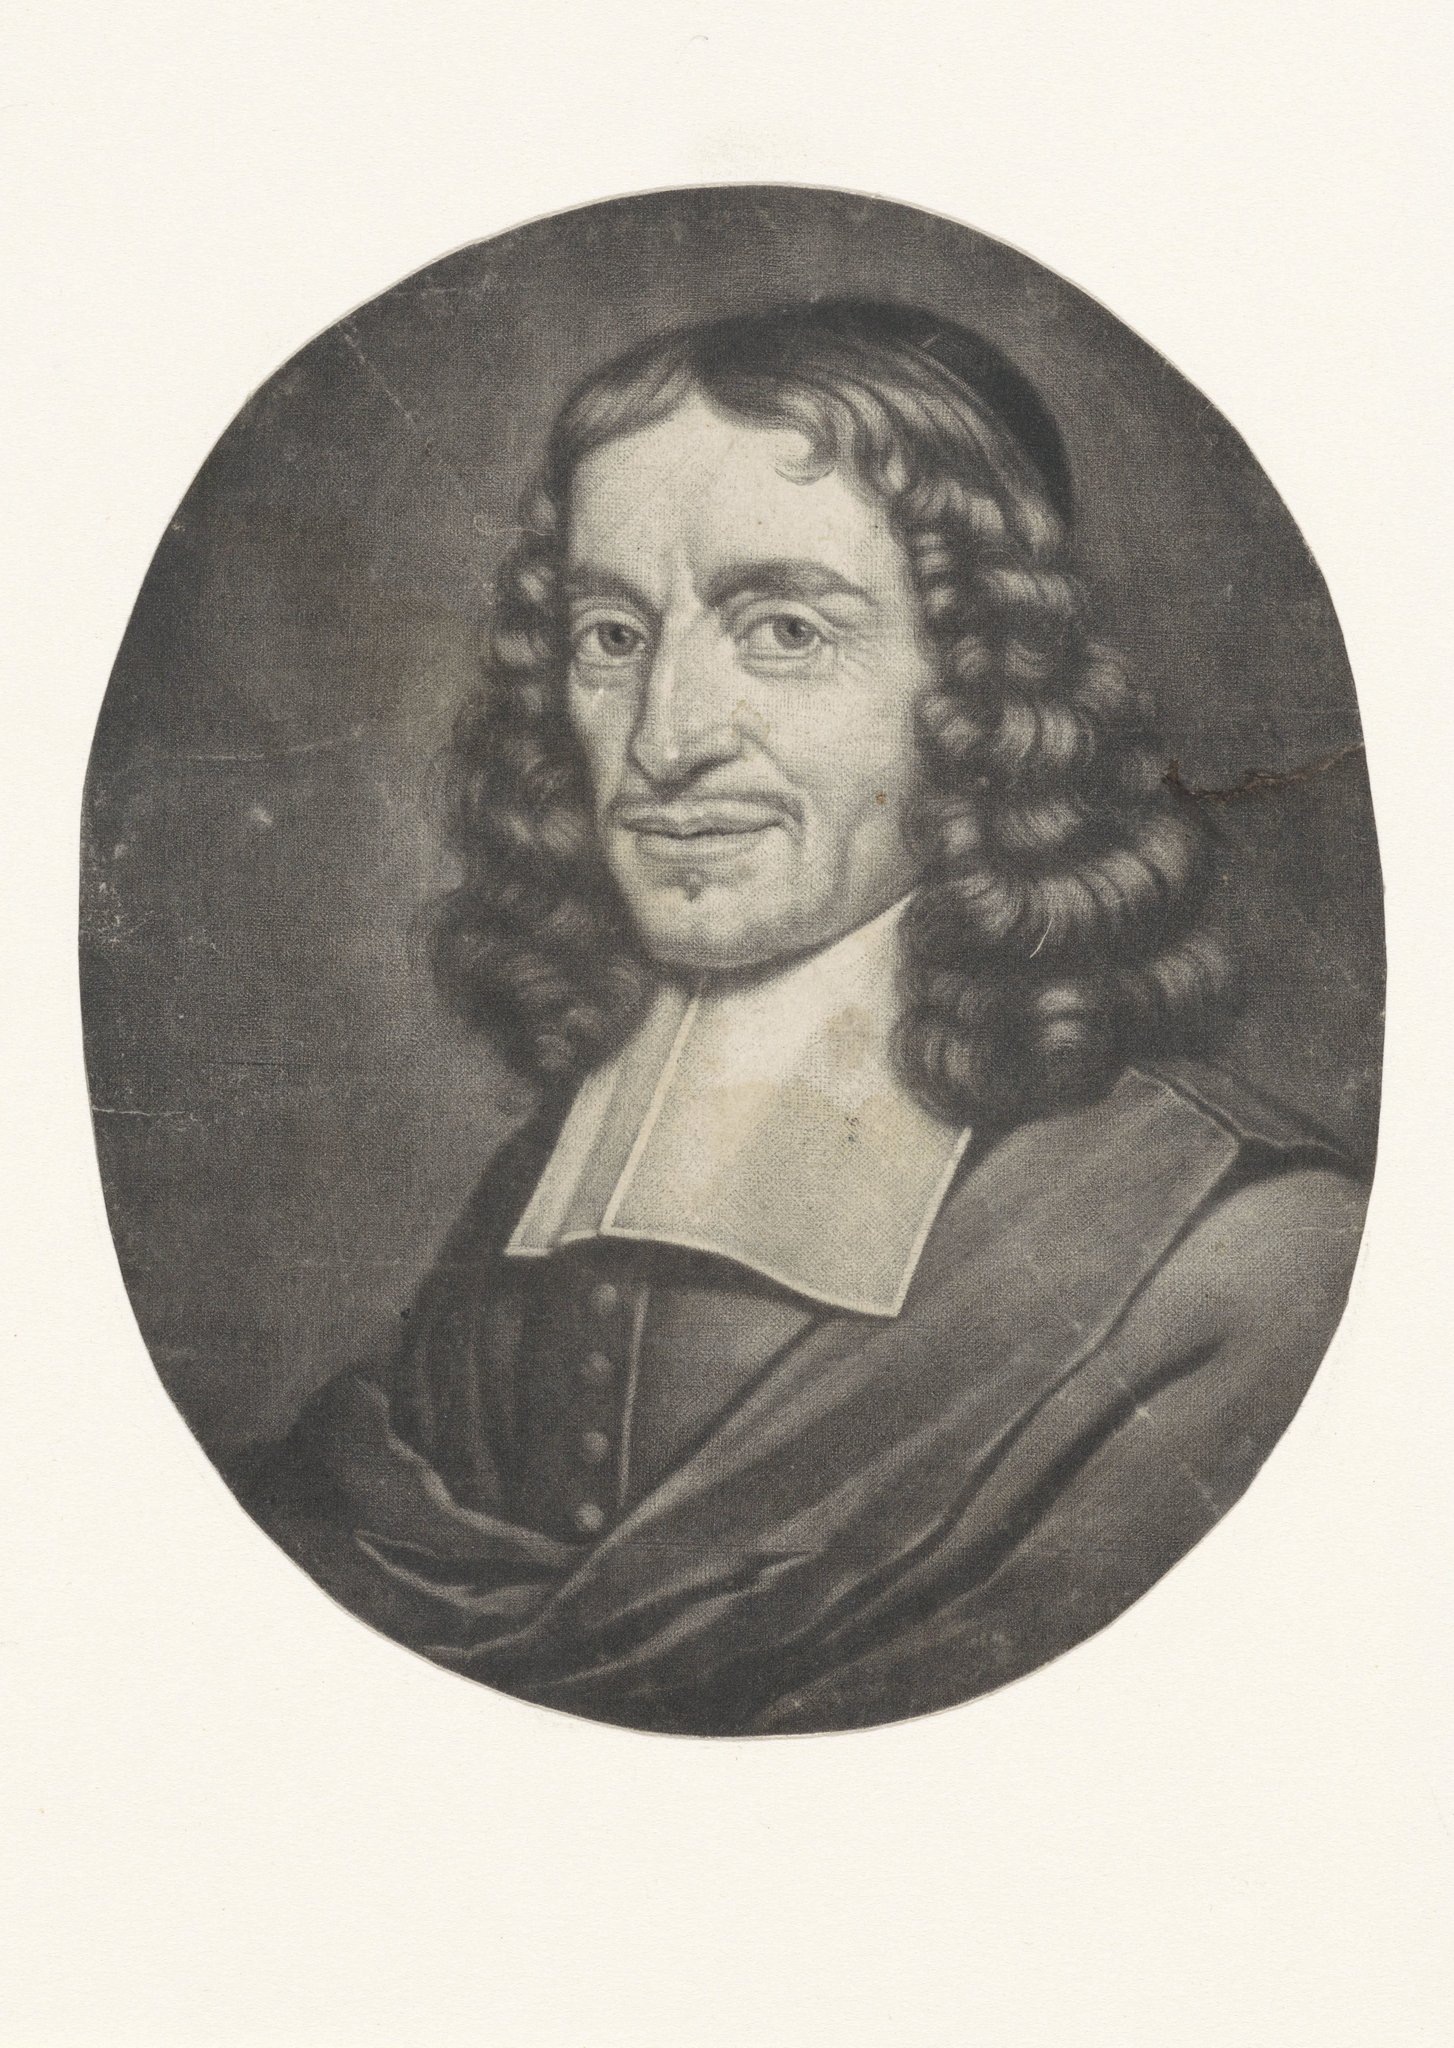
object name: print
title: Portret van Geeraert Brandt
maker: pieter schenk (i)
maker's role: print maker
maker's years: 1660-1711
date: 1683-1713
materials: paper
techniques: mezzotint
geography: amsterdam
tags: amsterdam, geeraert brandt (i), theologian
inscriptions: collector's mark: Lugt 2228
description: Geeraert Brandt, historicus, dichter en toneelschrijver in Amsterdam.